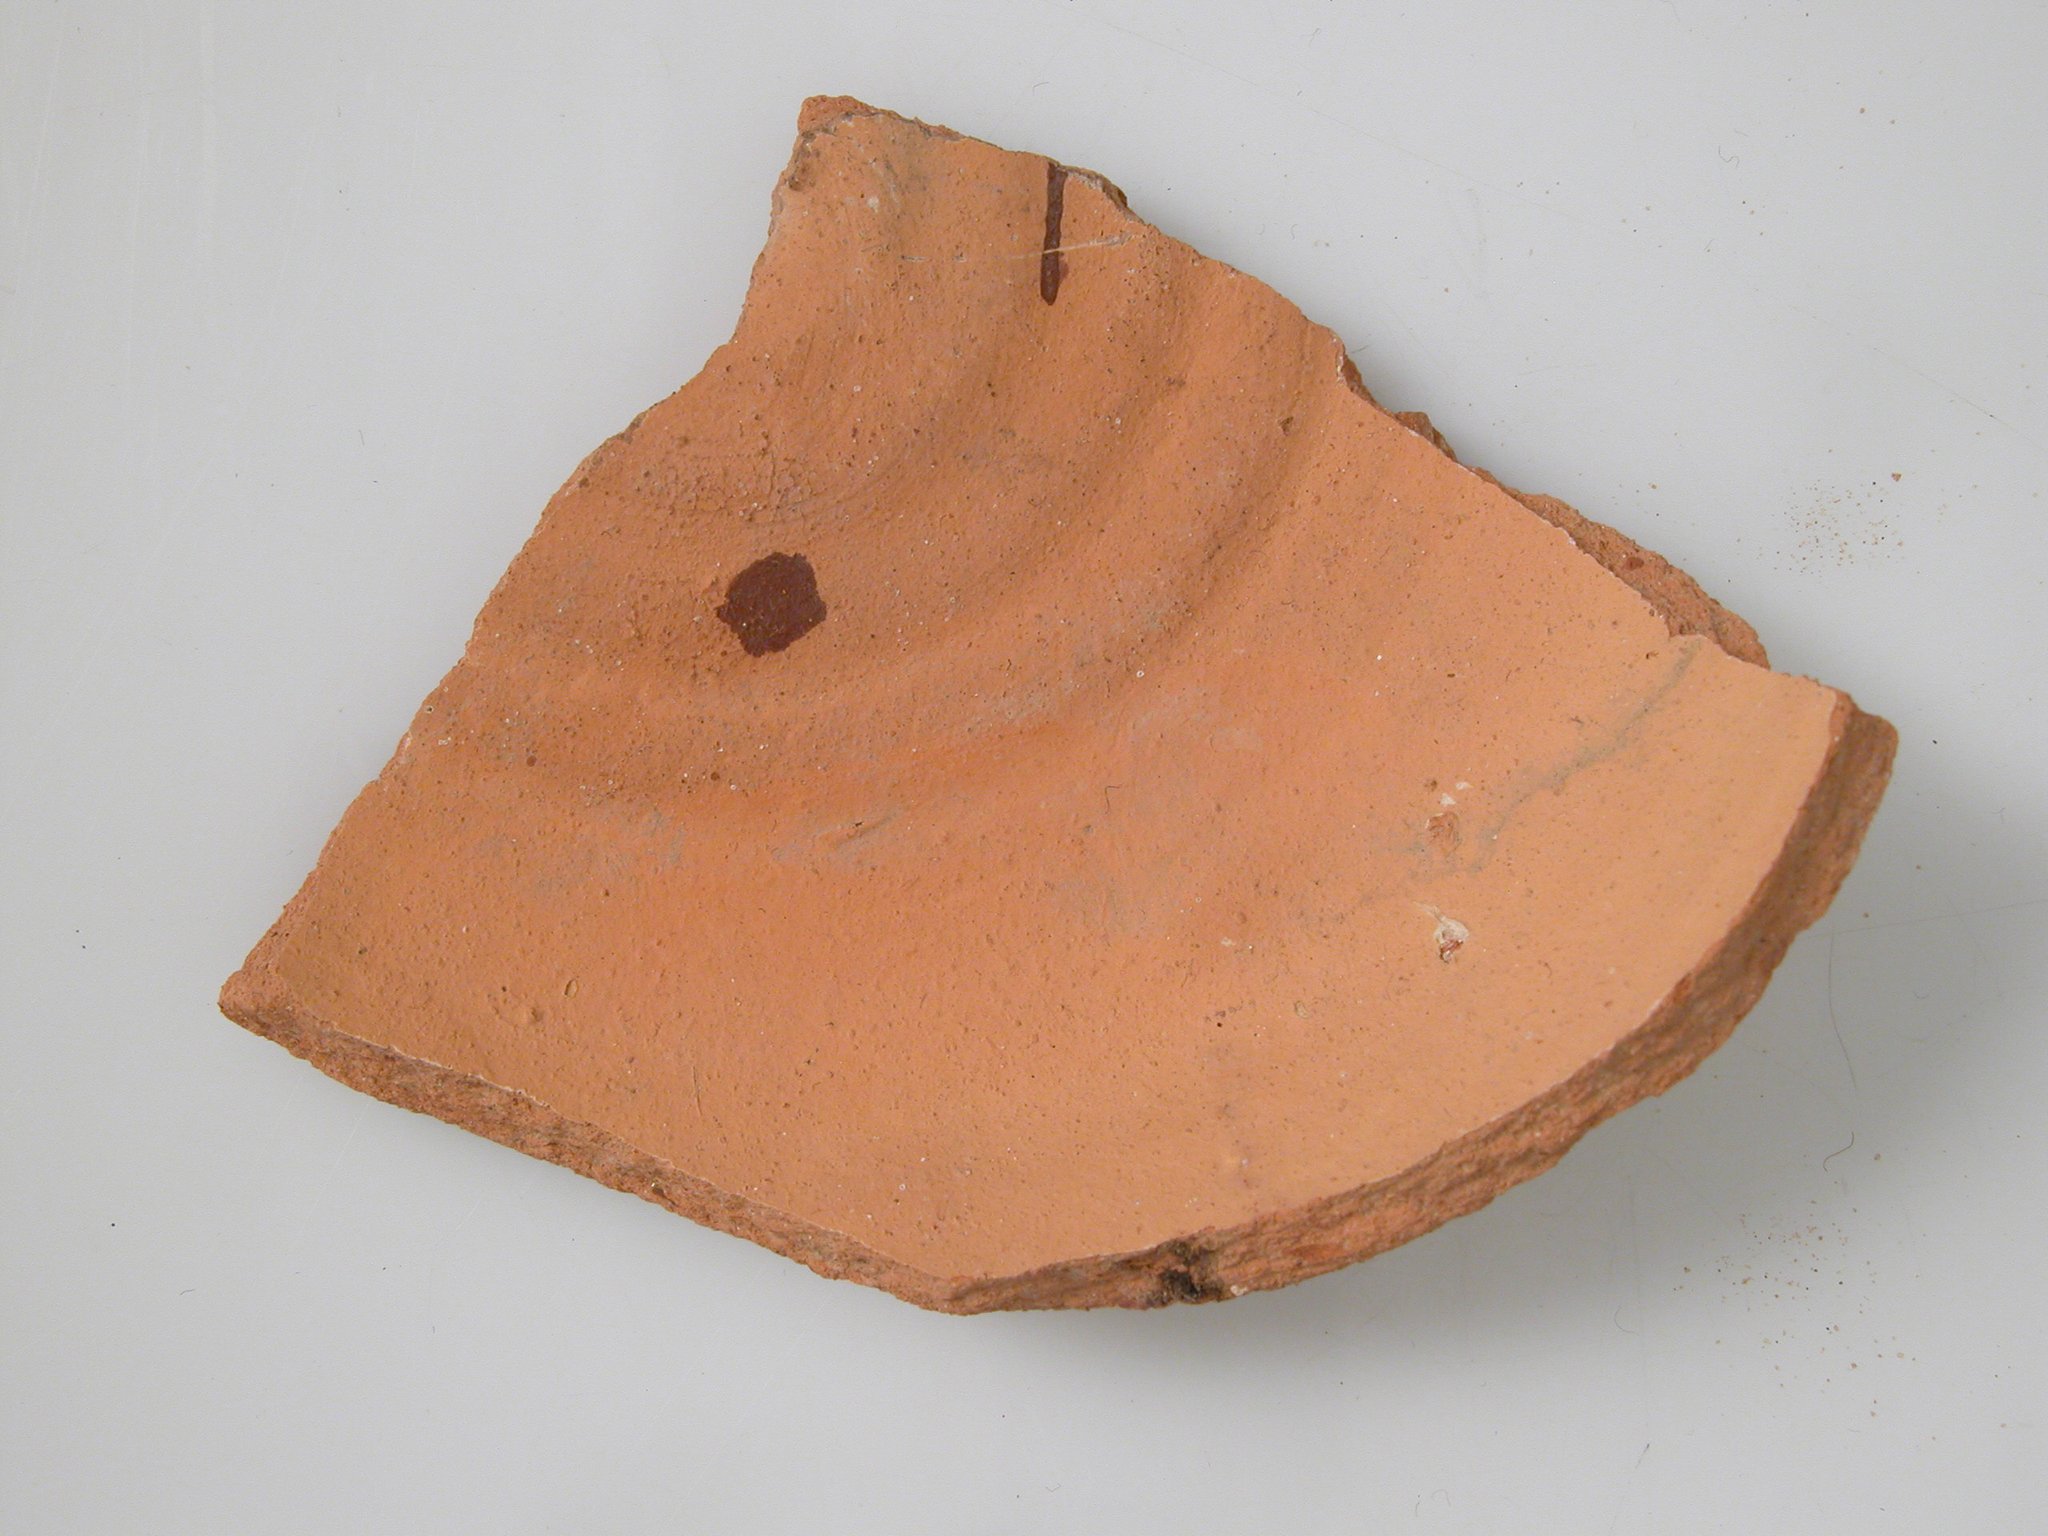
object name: fragment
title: Pottery Fragment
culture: coptic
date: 301-700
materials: earthenware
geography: egypt